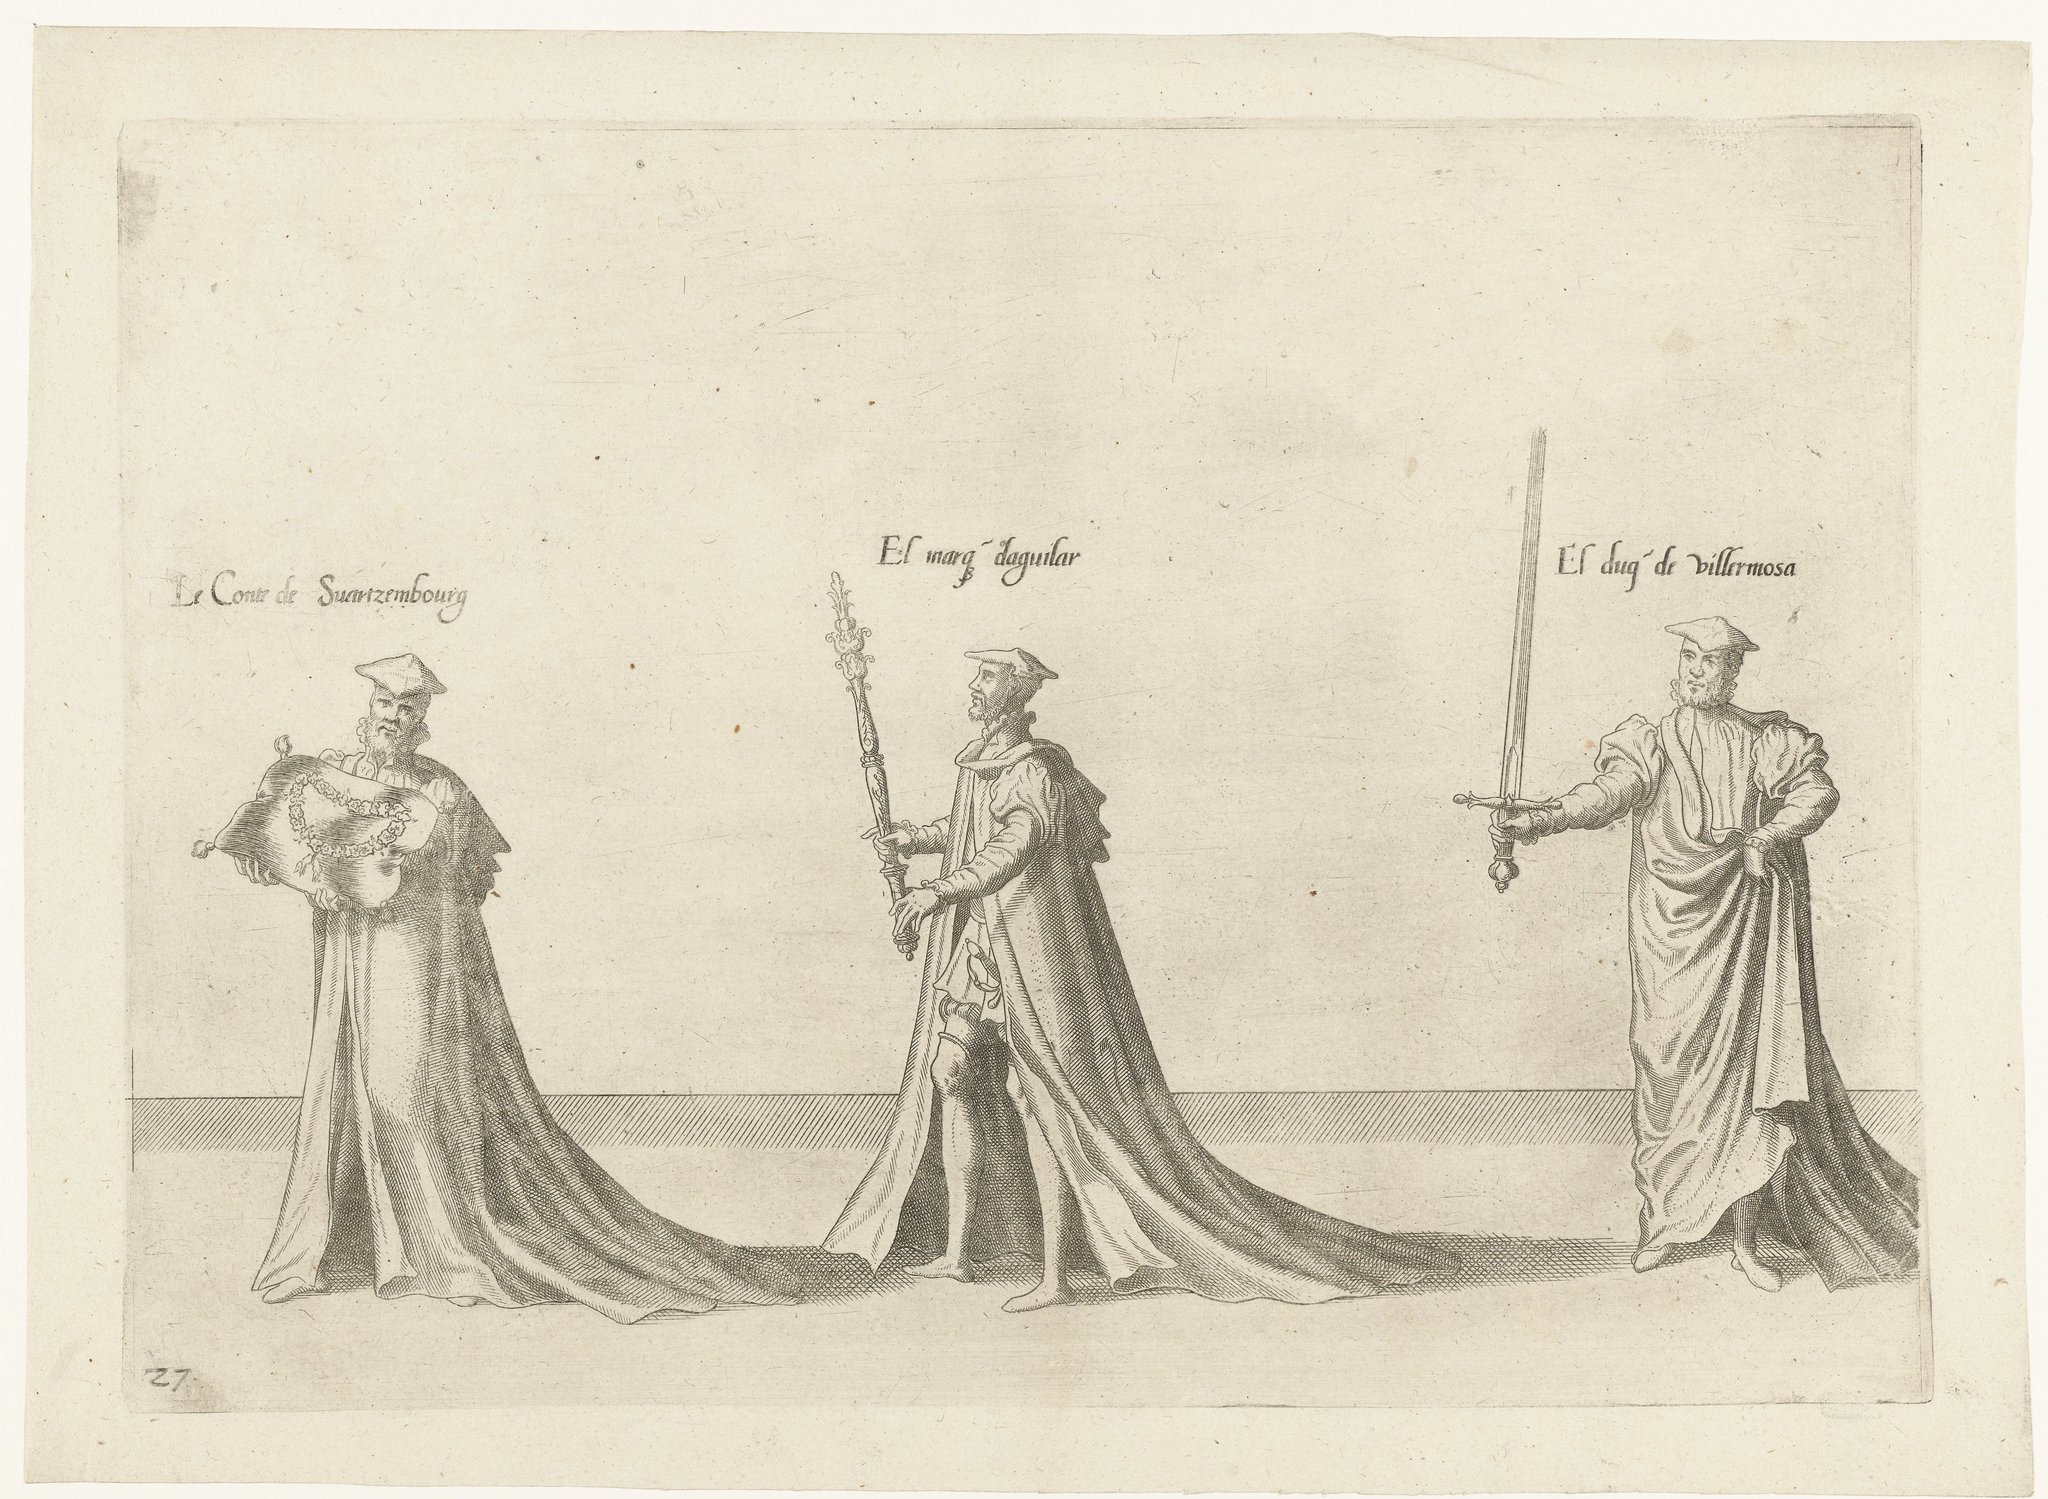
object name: print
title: Deel van de optocht, nr. 27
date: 1559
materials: paper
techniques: engraving, etching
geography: southern netherlands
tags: ghent, charles v (holy roman emperor and king of spain), cortege, funeral procession, brussels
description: Drie deelnemers aan de optocht, met zich meedragend de ketting met de orde van het Gulden Vlies, de scepter en het zwaard. Onderdeel van de prentreeks van de Begrafenisoptocht van keizer Karel V op 29 december 1558 te Brussel.